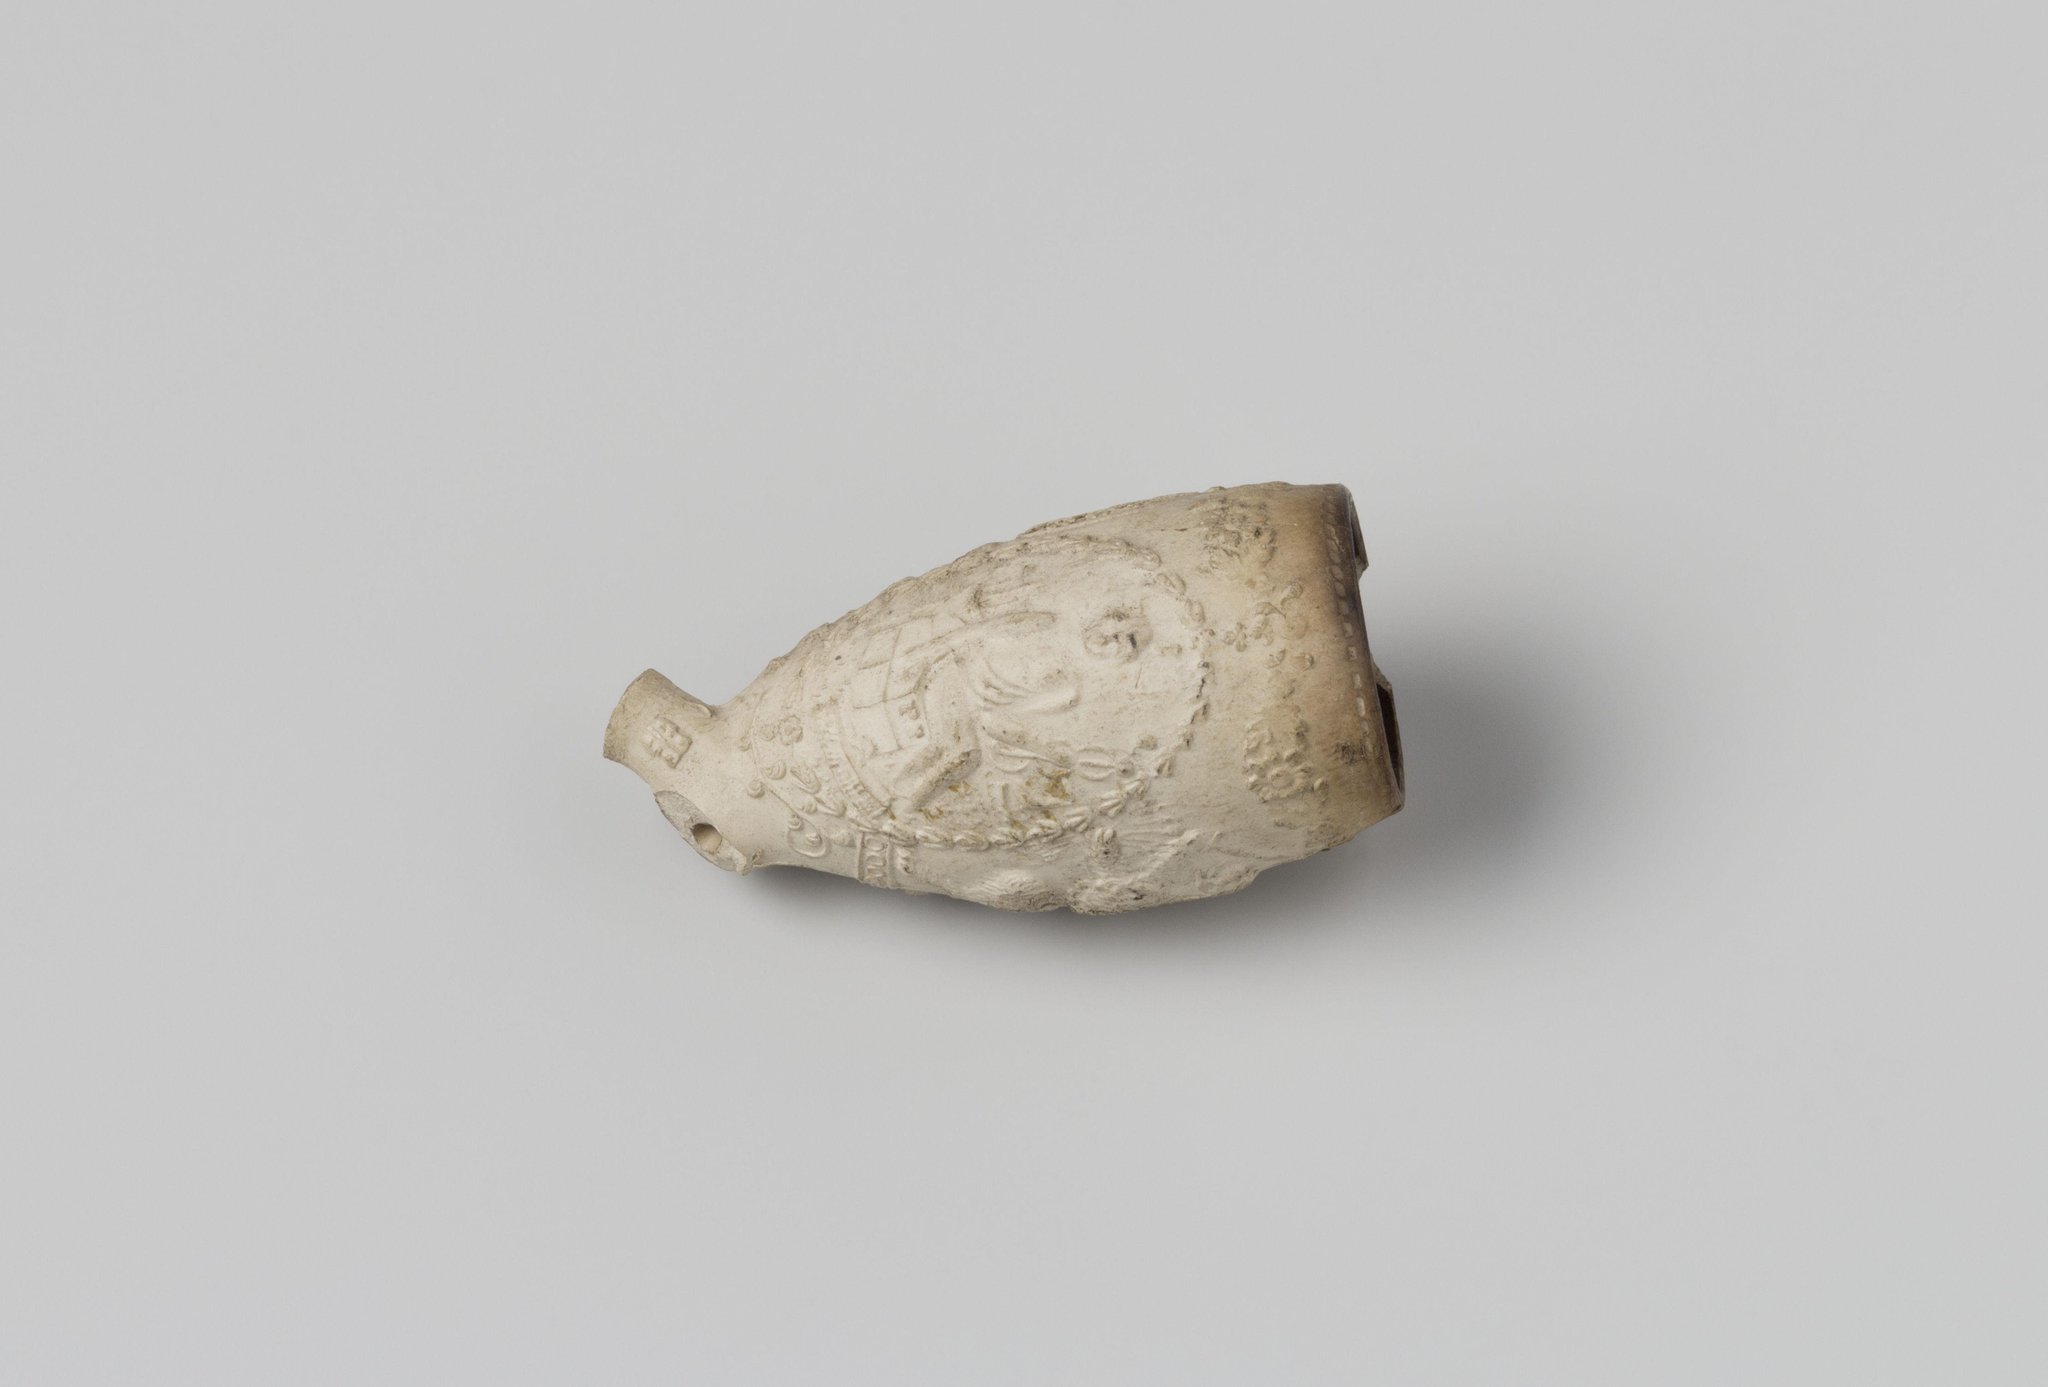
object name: fragment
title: Fragment pijpenkop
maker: adrianus frans sparnaaij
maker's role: pijpenfabrikant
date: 1814-1830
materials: clay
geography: gouda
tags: the hague, rotterdam